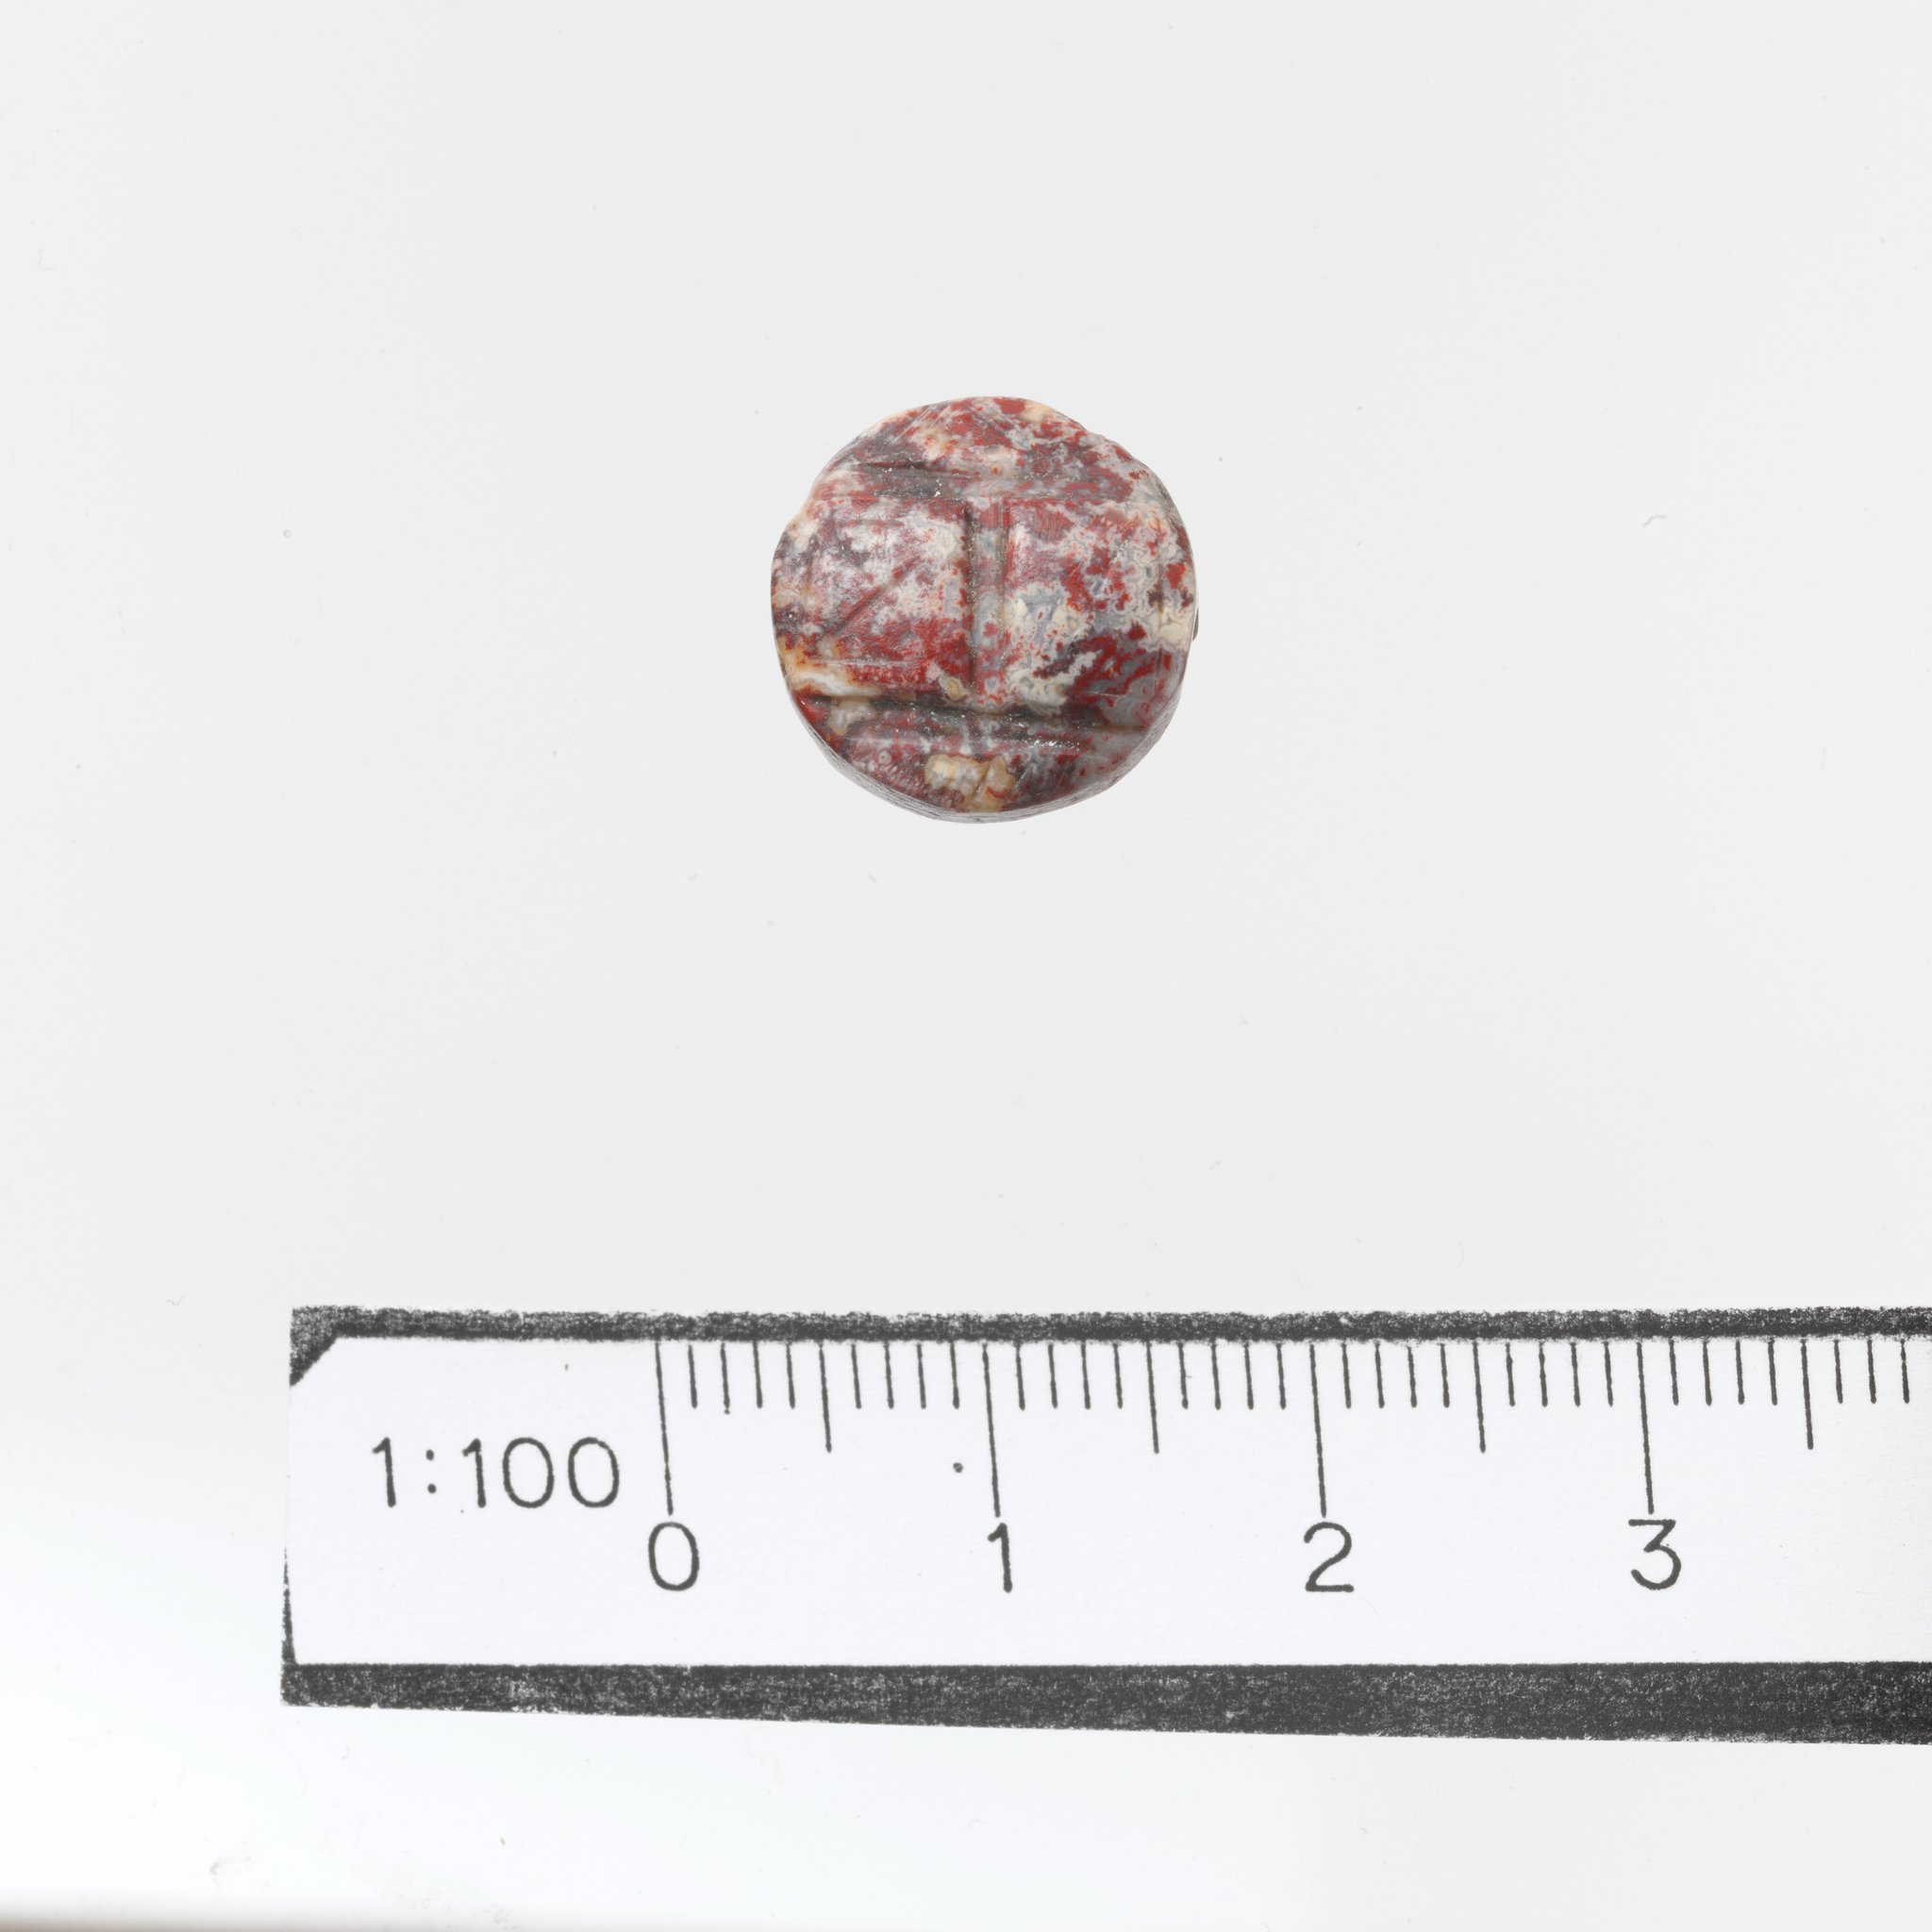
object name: seal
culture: minoan, crete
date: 2000-1450 BCE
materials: jasper, quartz